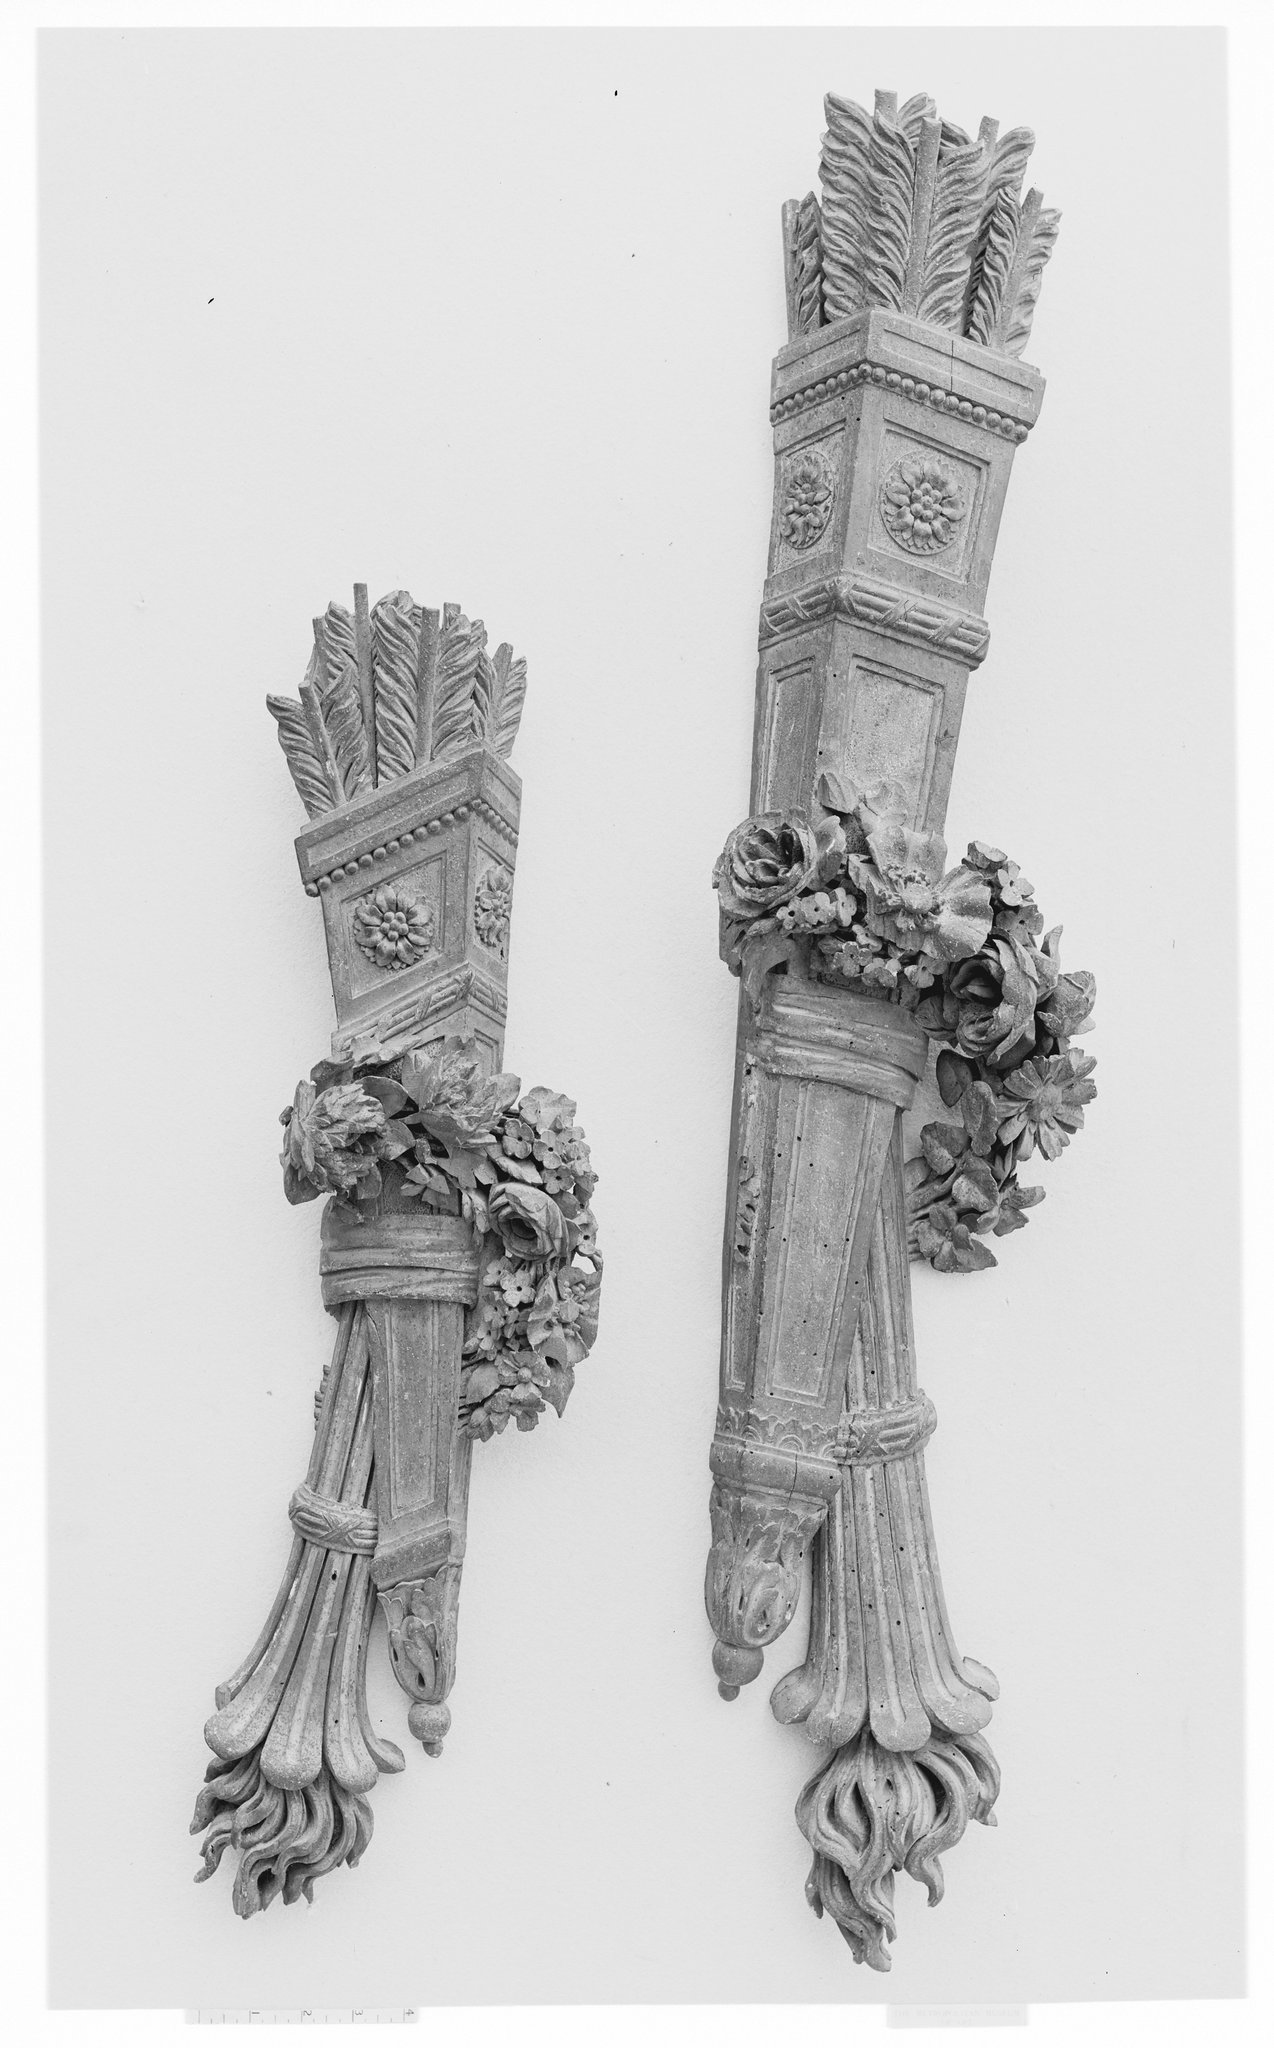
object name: trophy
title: Trophy (part of a set)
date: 1701-1800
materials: gilt, wood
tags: garlands,flowers,trophies